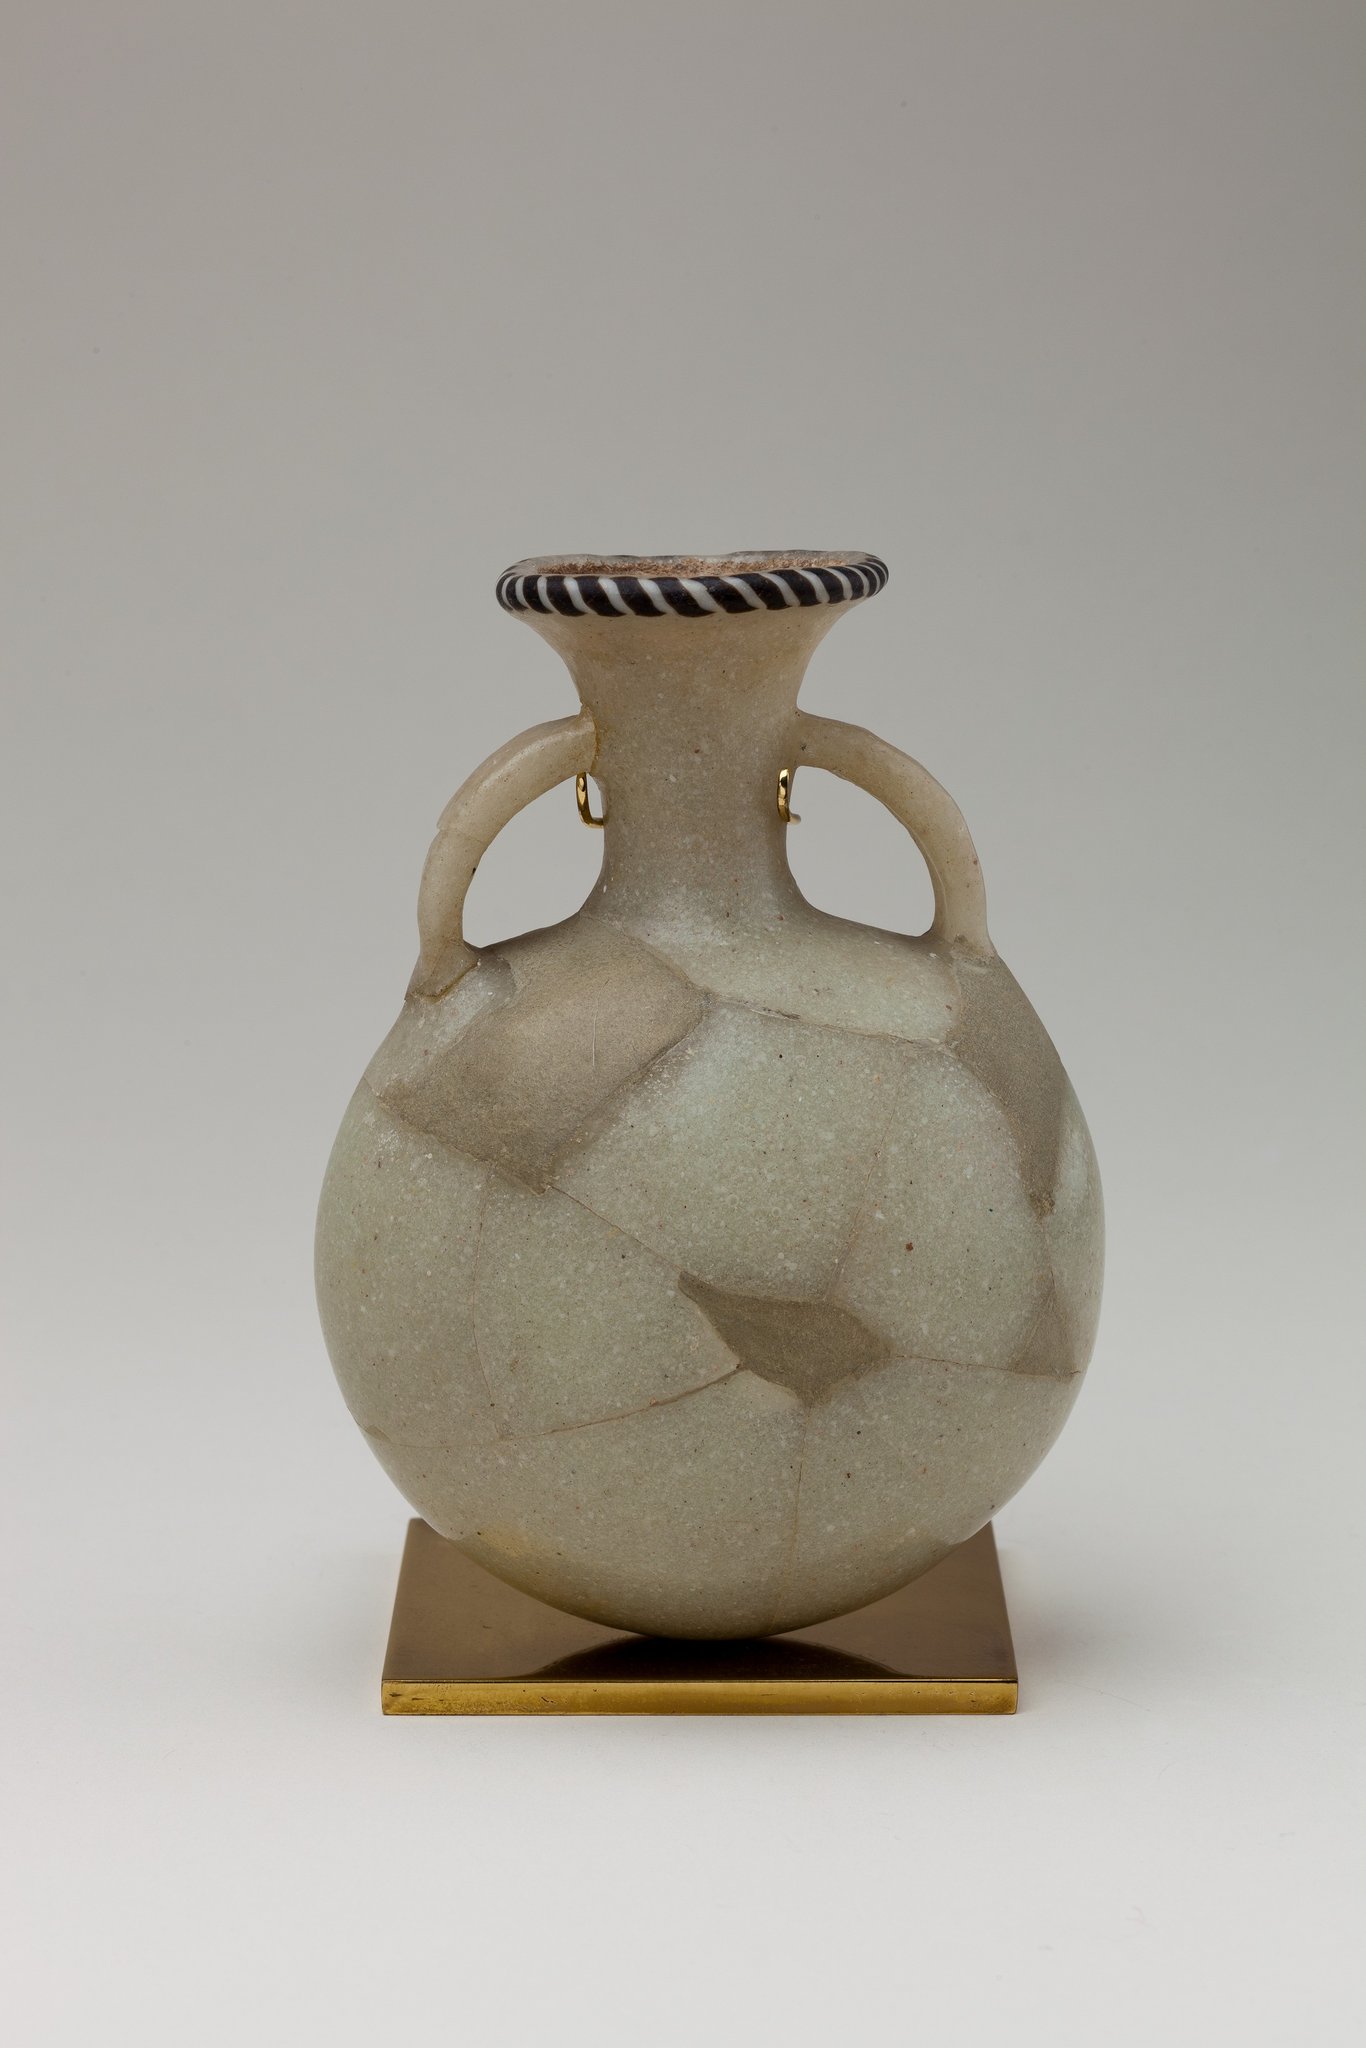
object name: bottle vase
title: Bottle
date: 1295-1070 BCE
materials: glass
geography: egypt